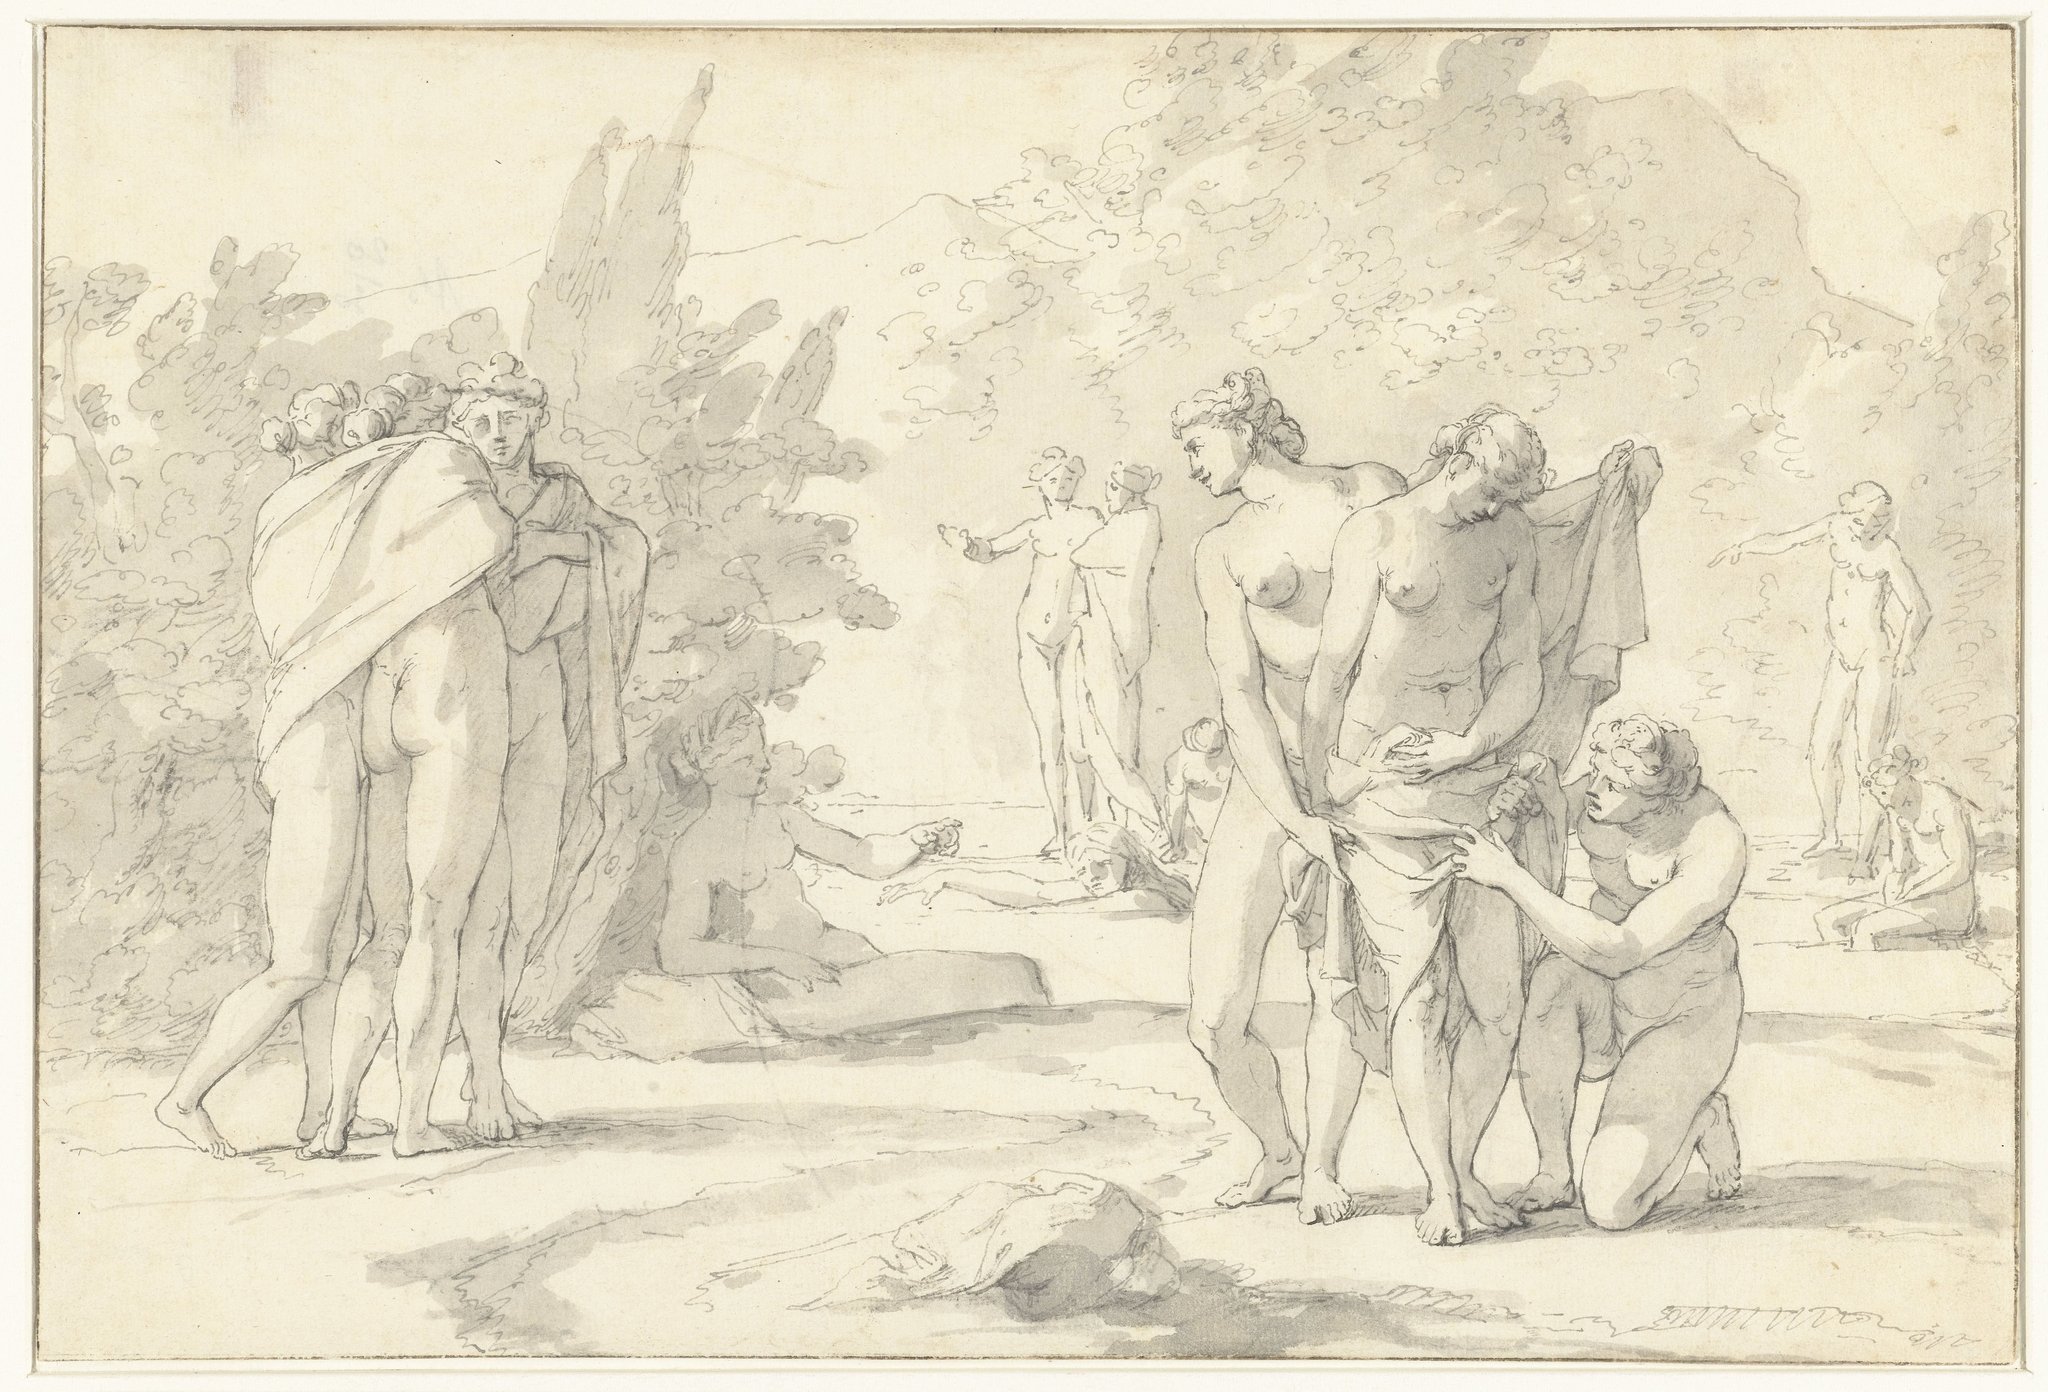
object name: drawing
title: Diana en haar gezellinnen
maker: Anonymous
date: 1600-1699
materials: ink, paper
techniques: brush, pen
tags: diana bathing with her nymphs